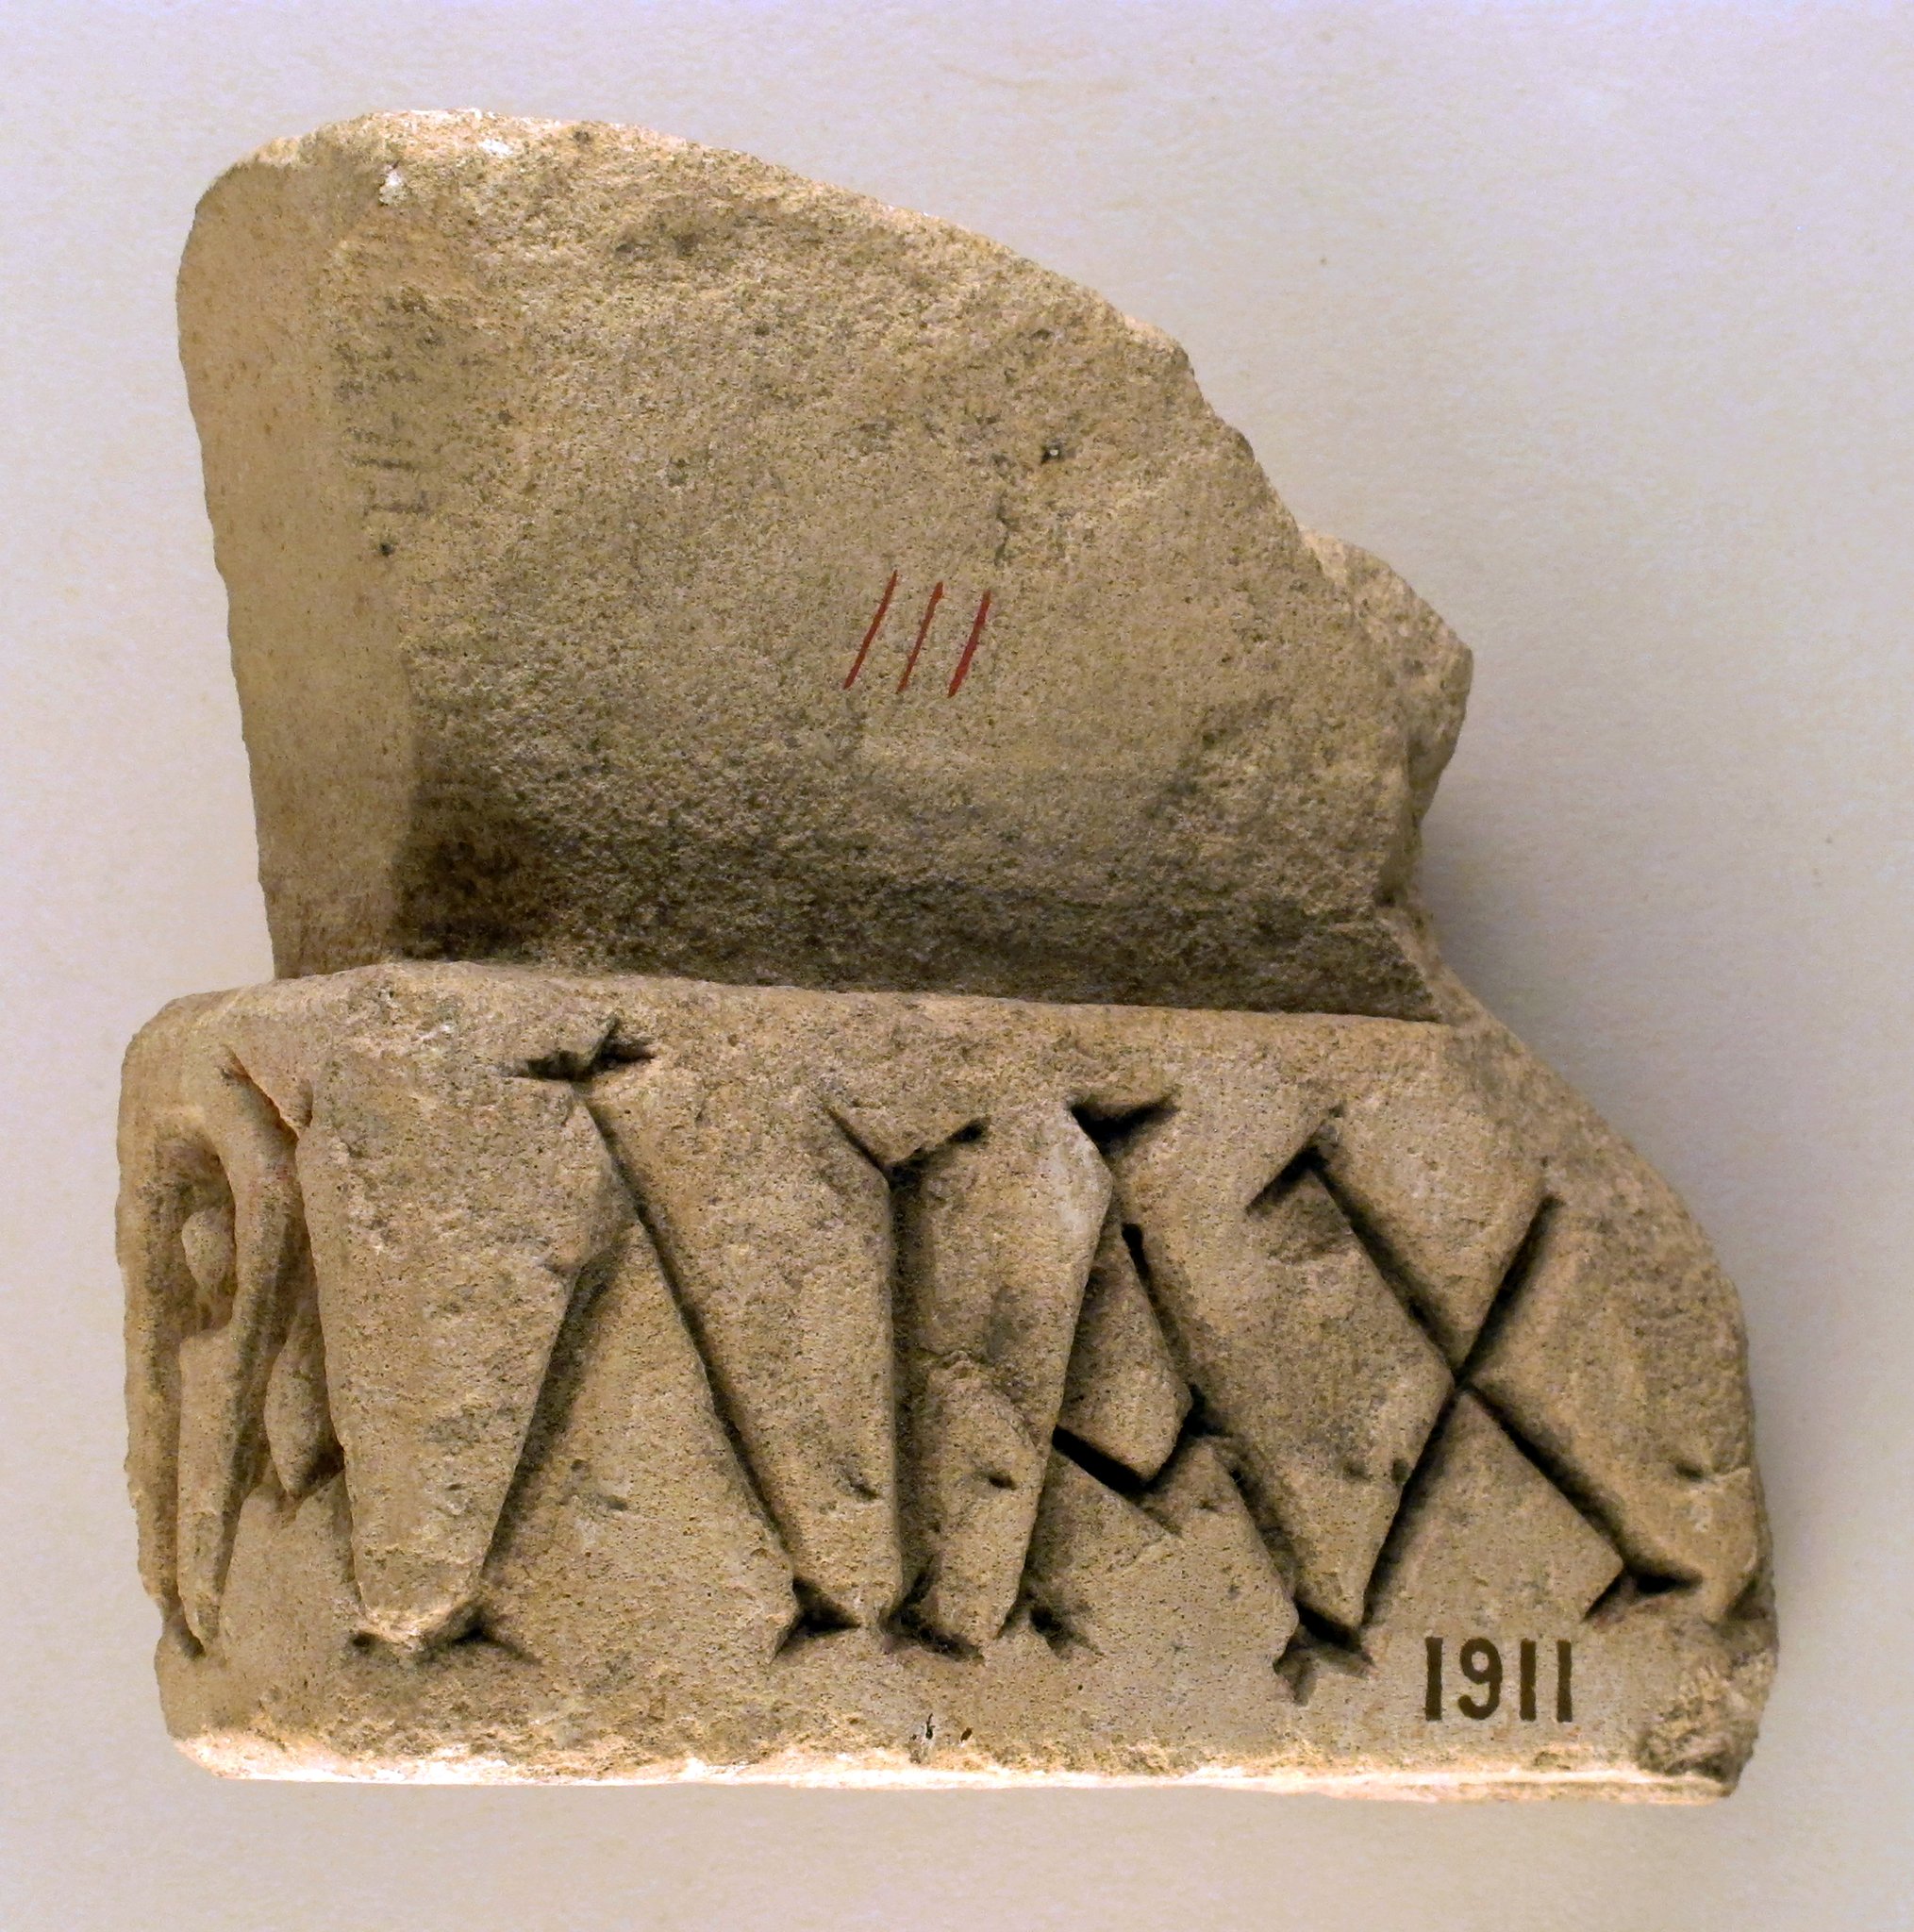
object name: statue base, pedestal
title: Inscribed limestone base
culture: roman, cypriot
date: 101-300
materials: limestone